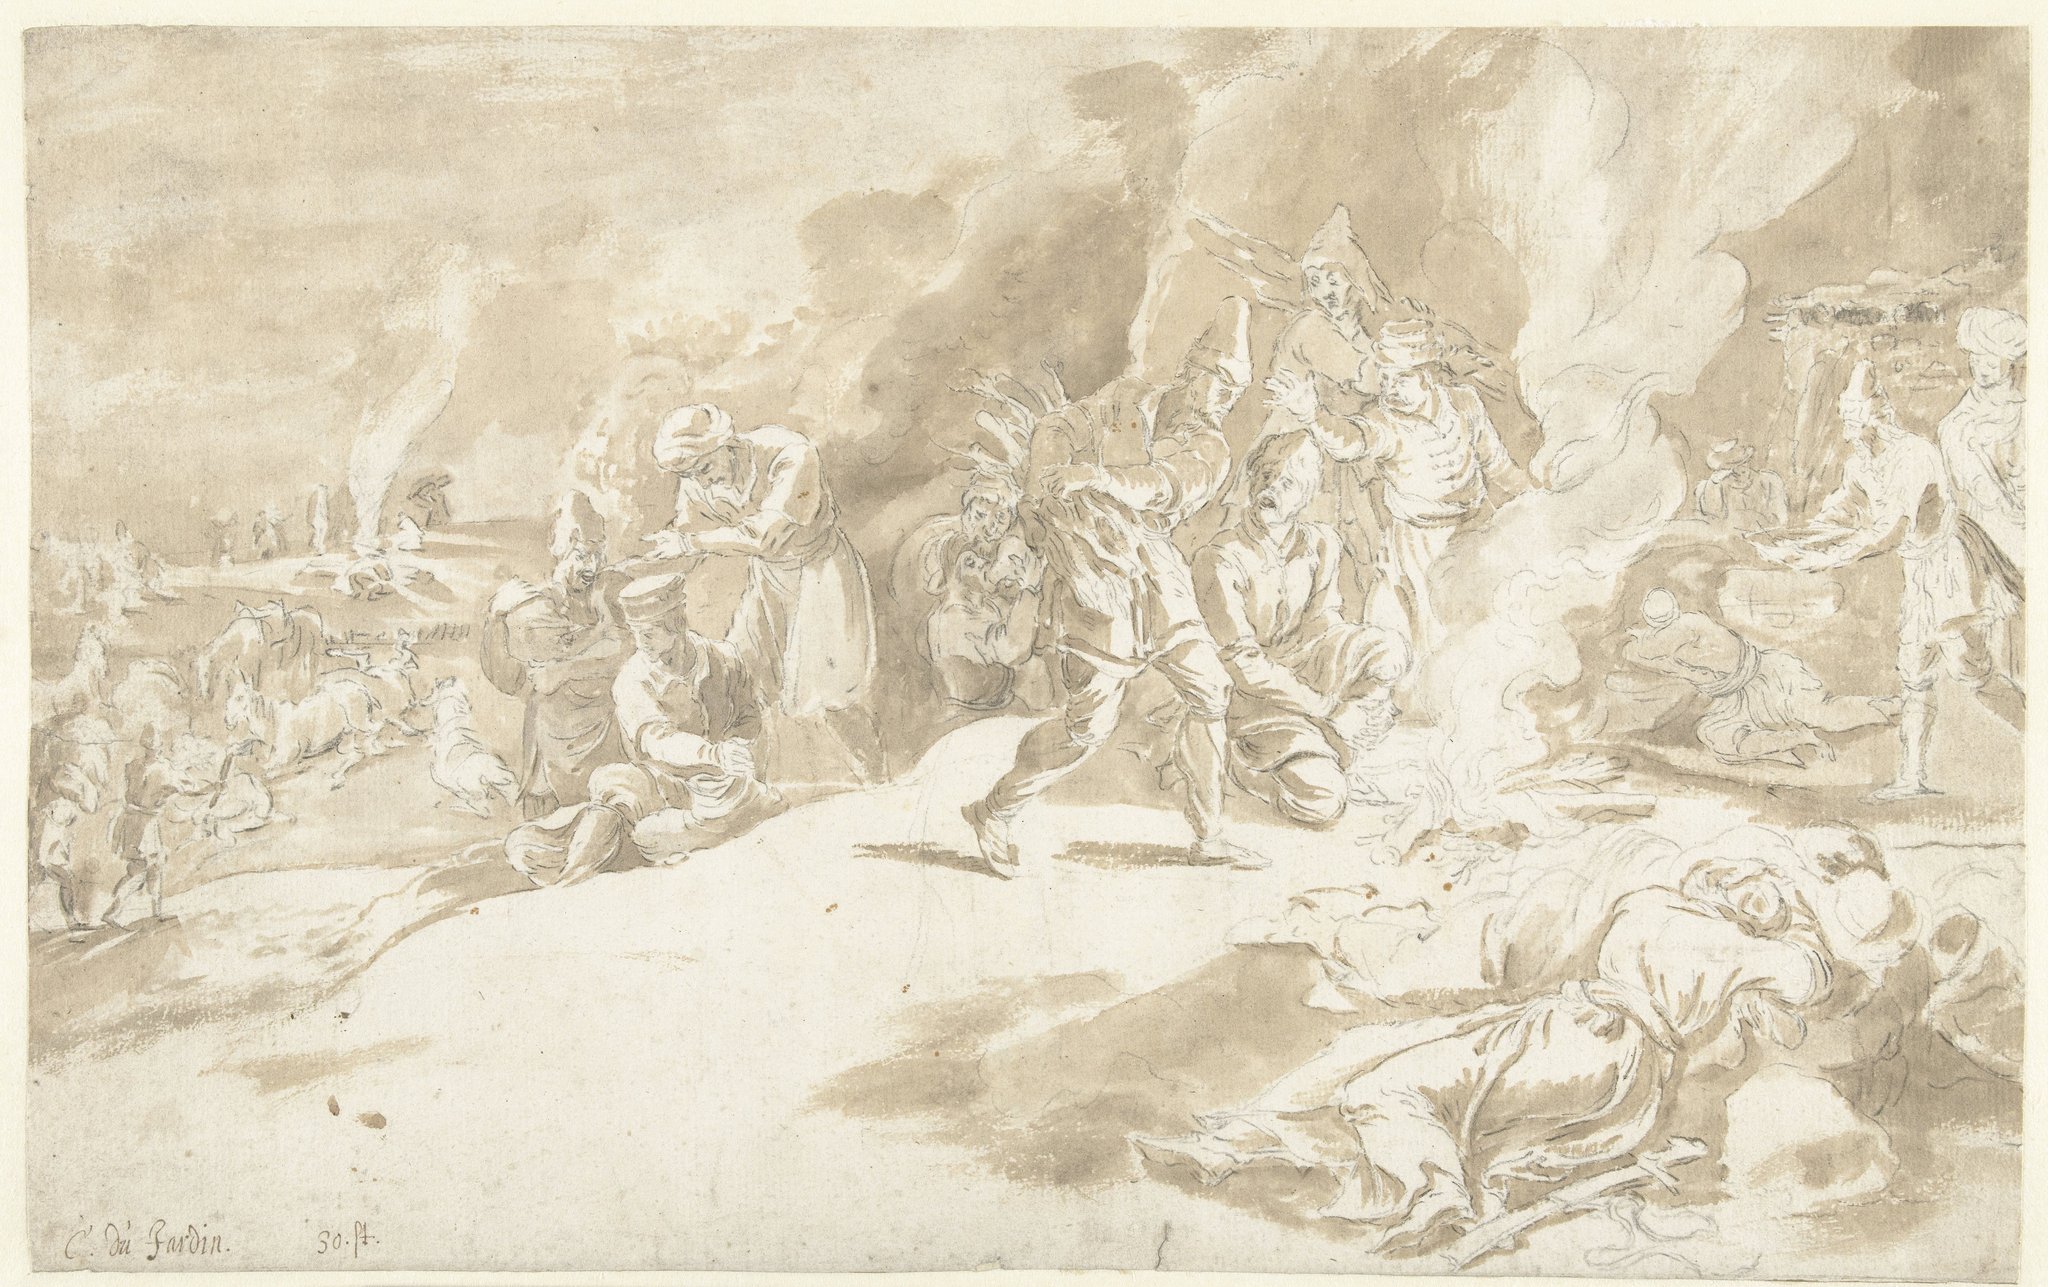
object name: drawing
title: Turkish Soldiers around a Camp Fire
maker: guilliam du gardijn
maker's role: draughtsman, painter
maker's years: 1595-1657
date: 1605-1647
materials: graphite, paper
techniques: brush